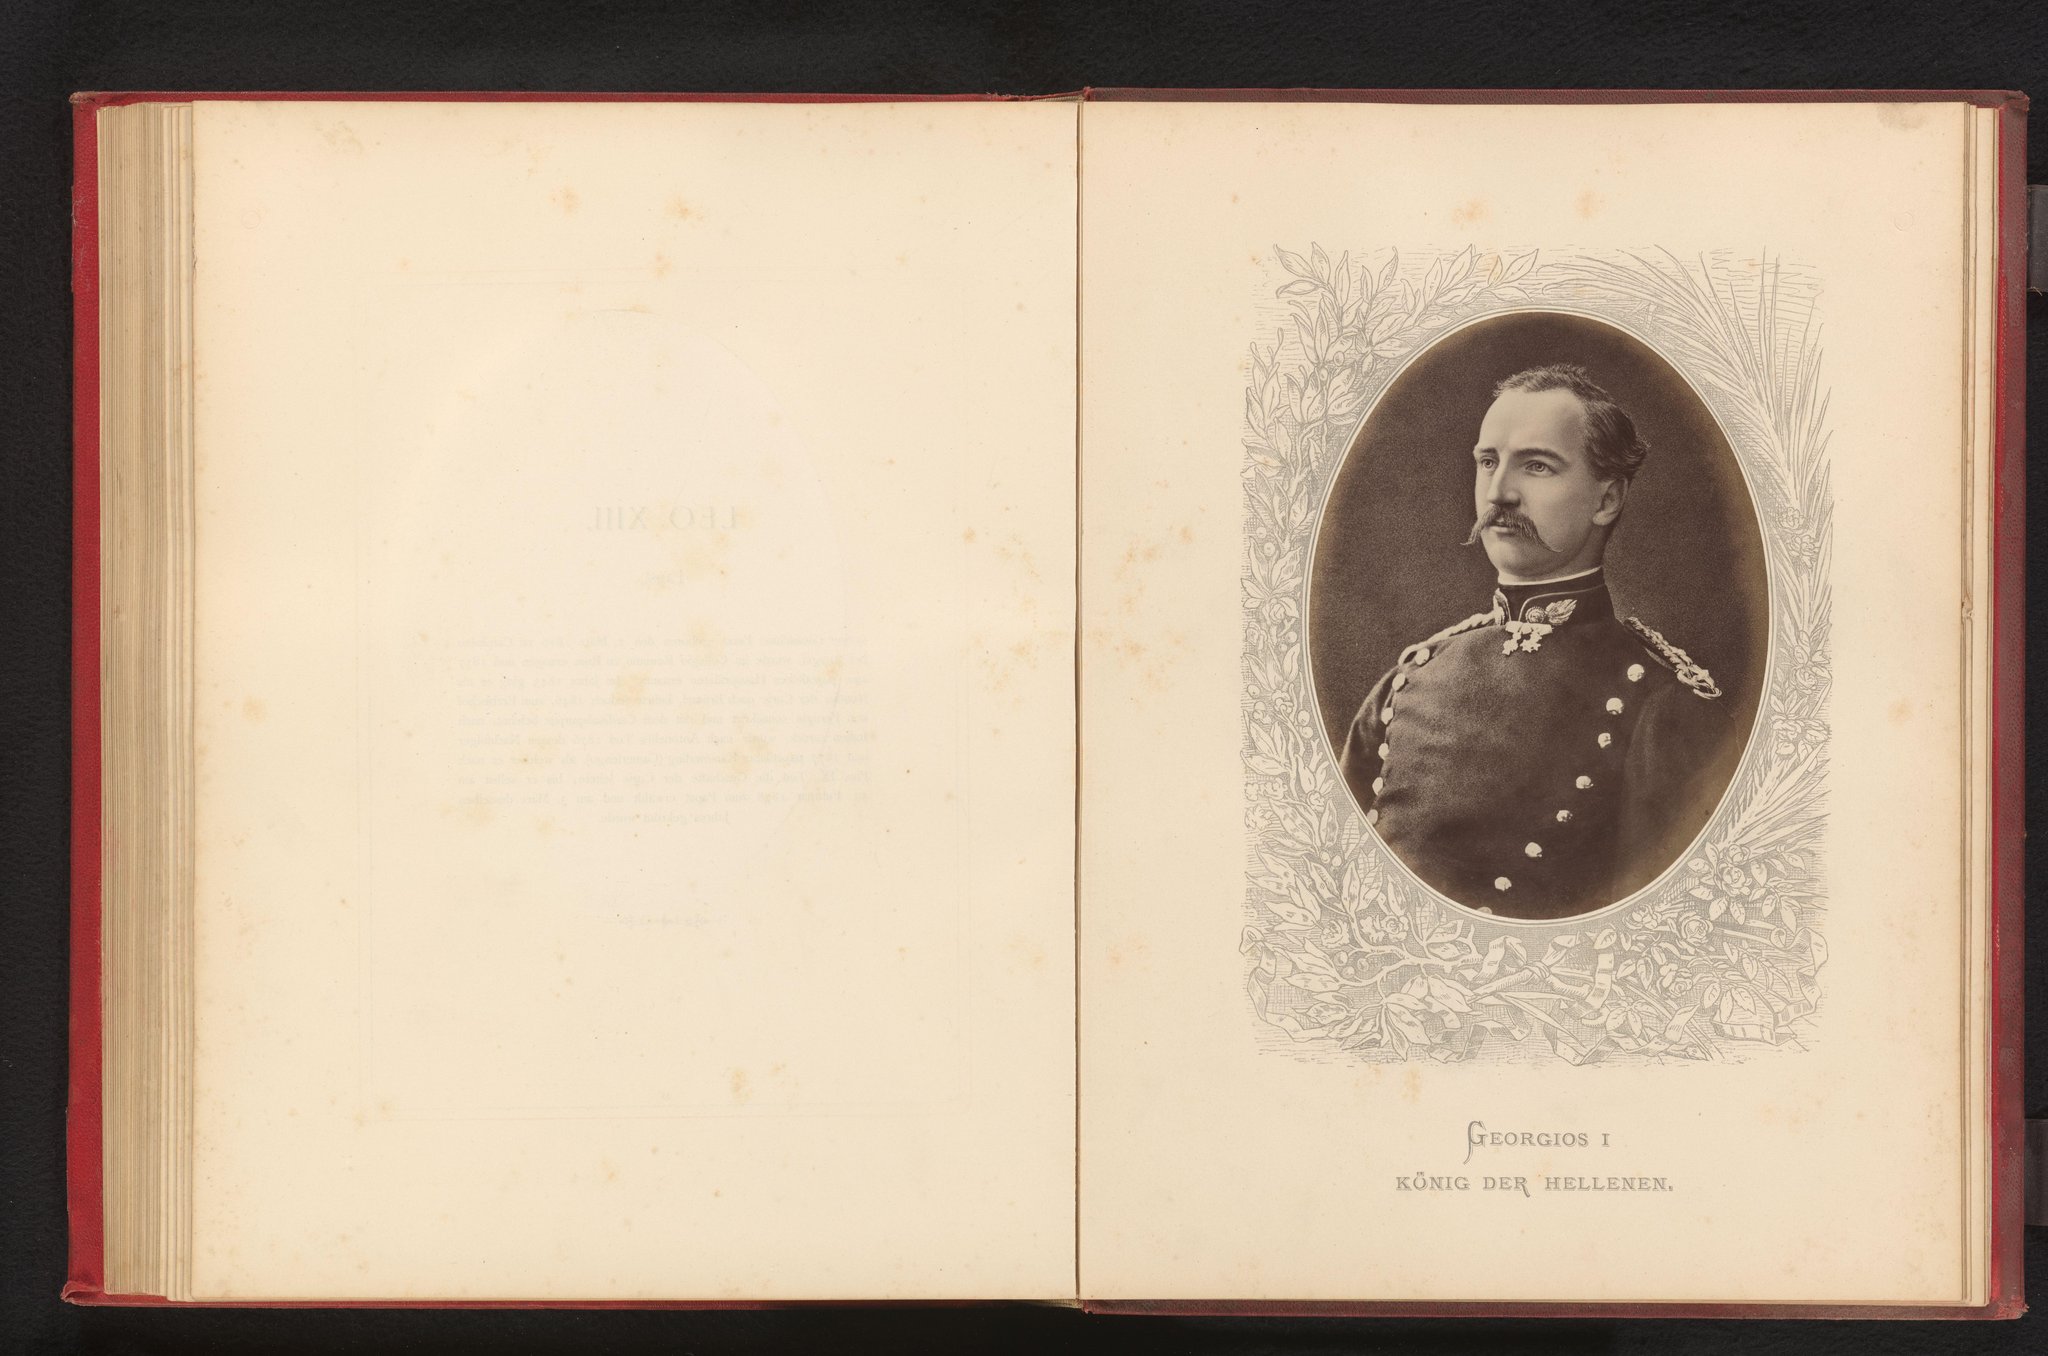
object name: photograph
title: Portret van George I, koning van Griekenland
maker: Anonymous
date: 1875-1880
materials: paper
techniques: albumen print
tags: copenhagen (city), historical persons, king